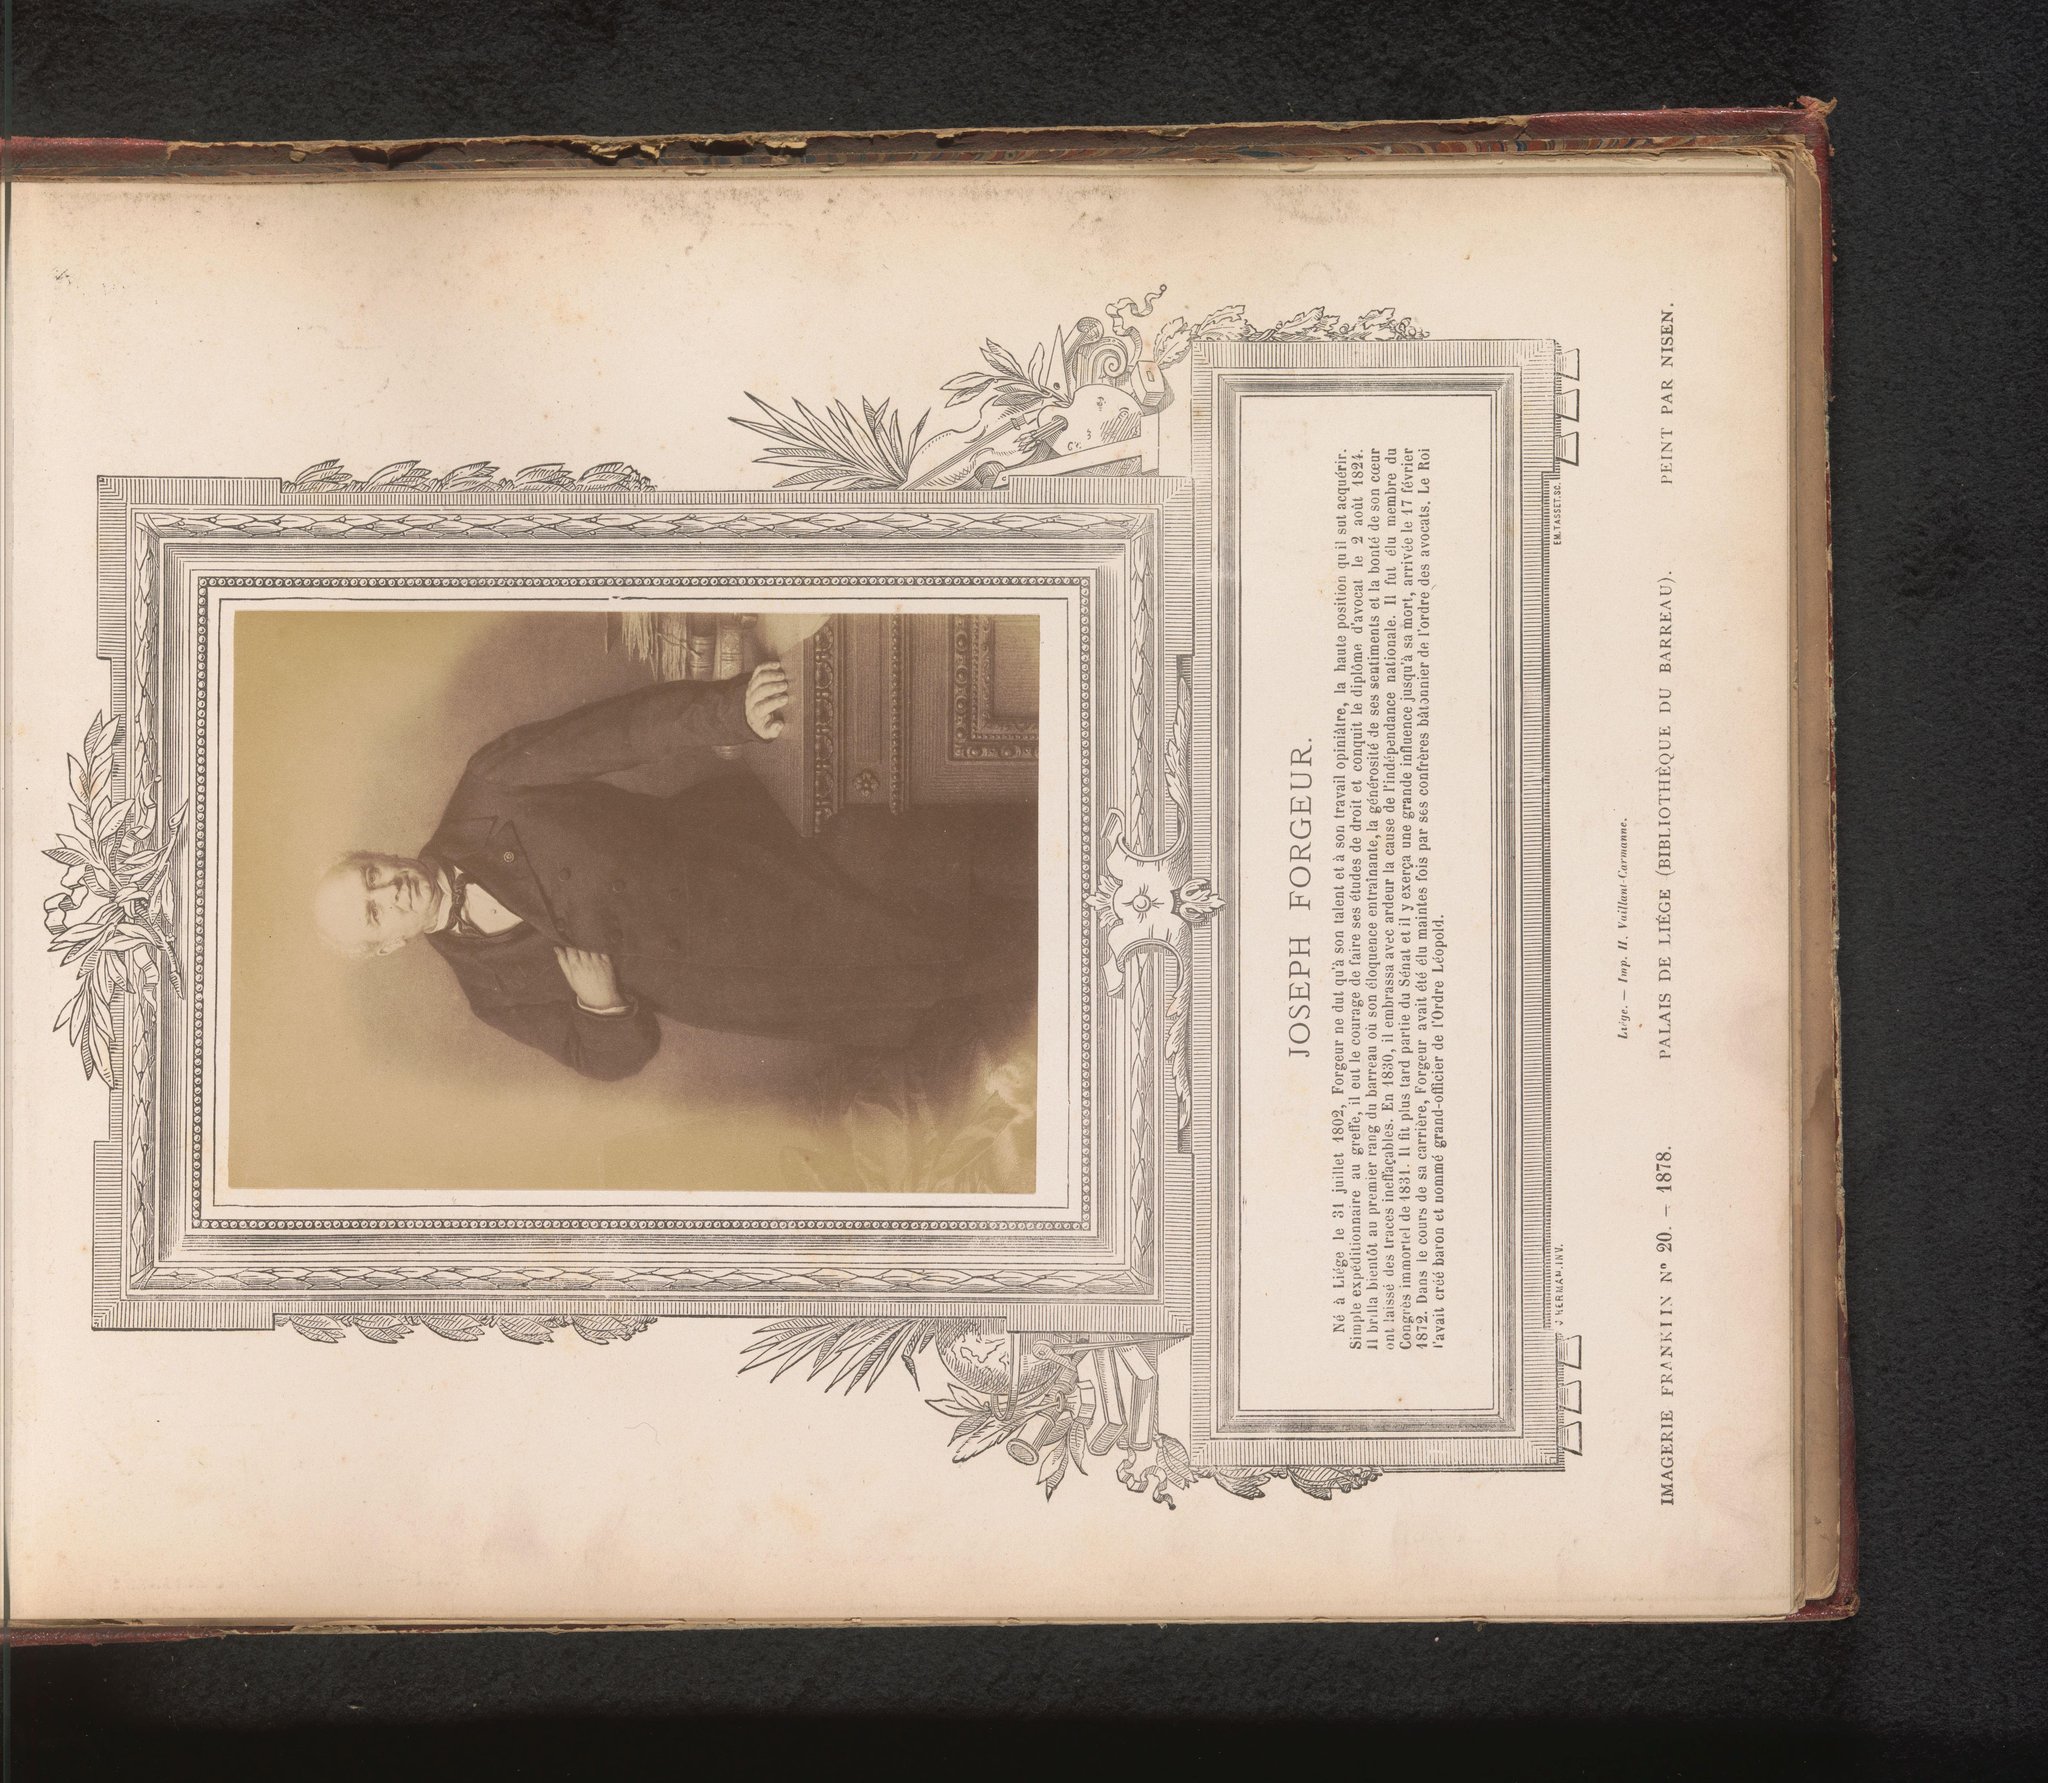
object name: photograph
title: La Chasse au Rat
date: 1873-1878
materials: photographic support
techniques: albumen print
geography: liège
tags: liège, politician, historical persons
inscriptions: inscription: ‘Né à Liége (...) l'Ordre Léopold.’, name: ‘EM. TASSET, SC.’, inscription: ‘IMAGERIE FRANKLIN No 20. - 1878.’, name: ‘J. HERMAN, INV.’, inscription: ‘PALAIS DE LIÉGE (BIBLIOTHÈQUE DU BARREAU).’